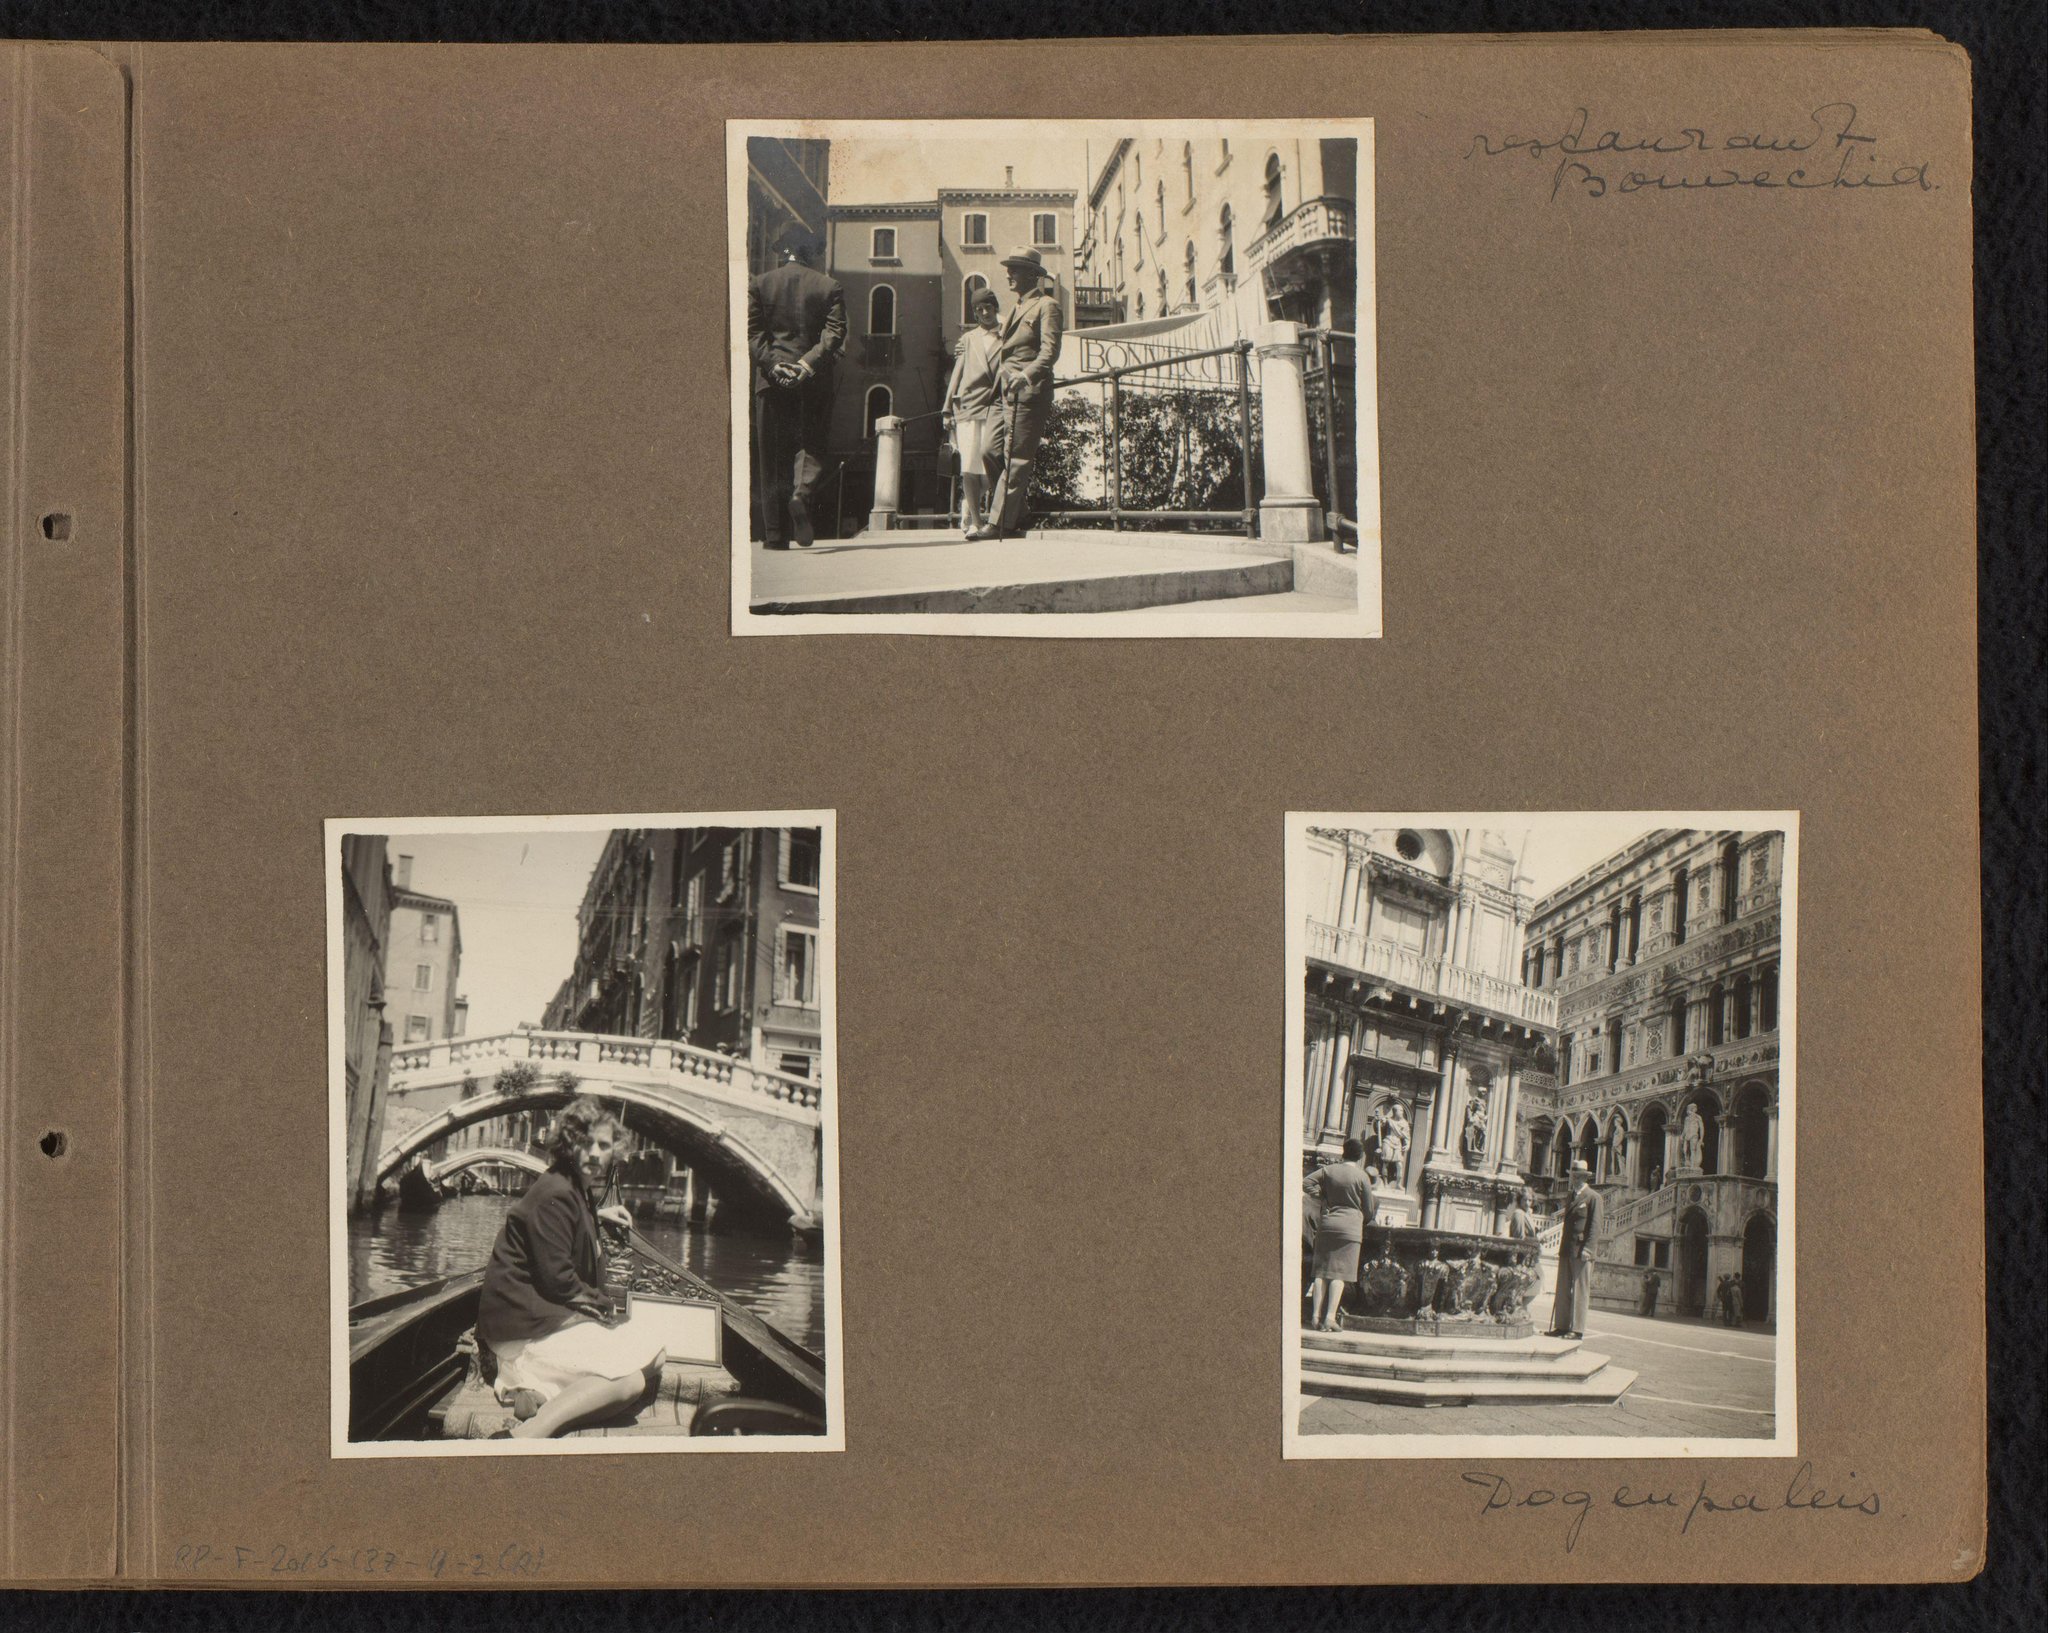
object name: photograph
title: Loentje en Frank Furnée in een gondel en bij het Dogepaleis, in Venetië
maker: carolina frederika onnen (lien/loen)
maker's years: 1896-1983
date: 1905-1928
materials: paper, cardboard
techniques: gelatin silver print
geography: venice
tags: the hague, amsterdam, carolina frederika onnen (lien/loen), historical persons, gondola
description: Deze foto's zijn onderdeel van een album.